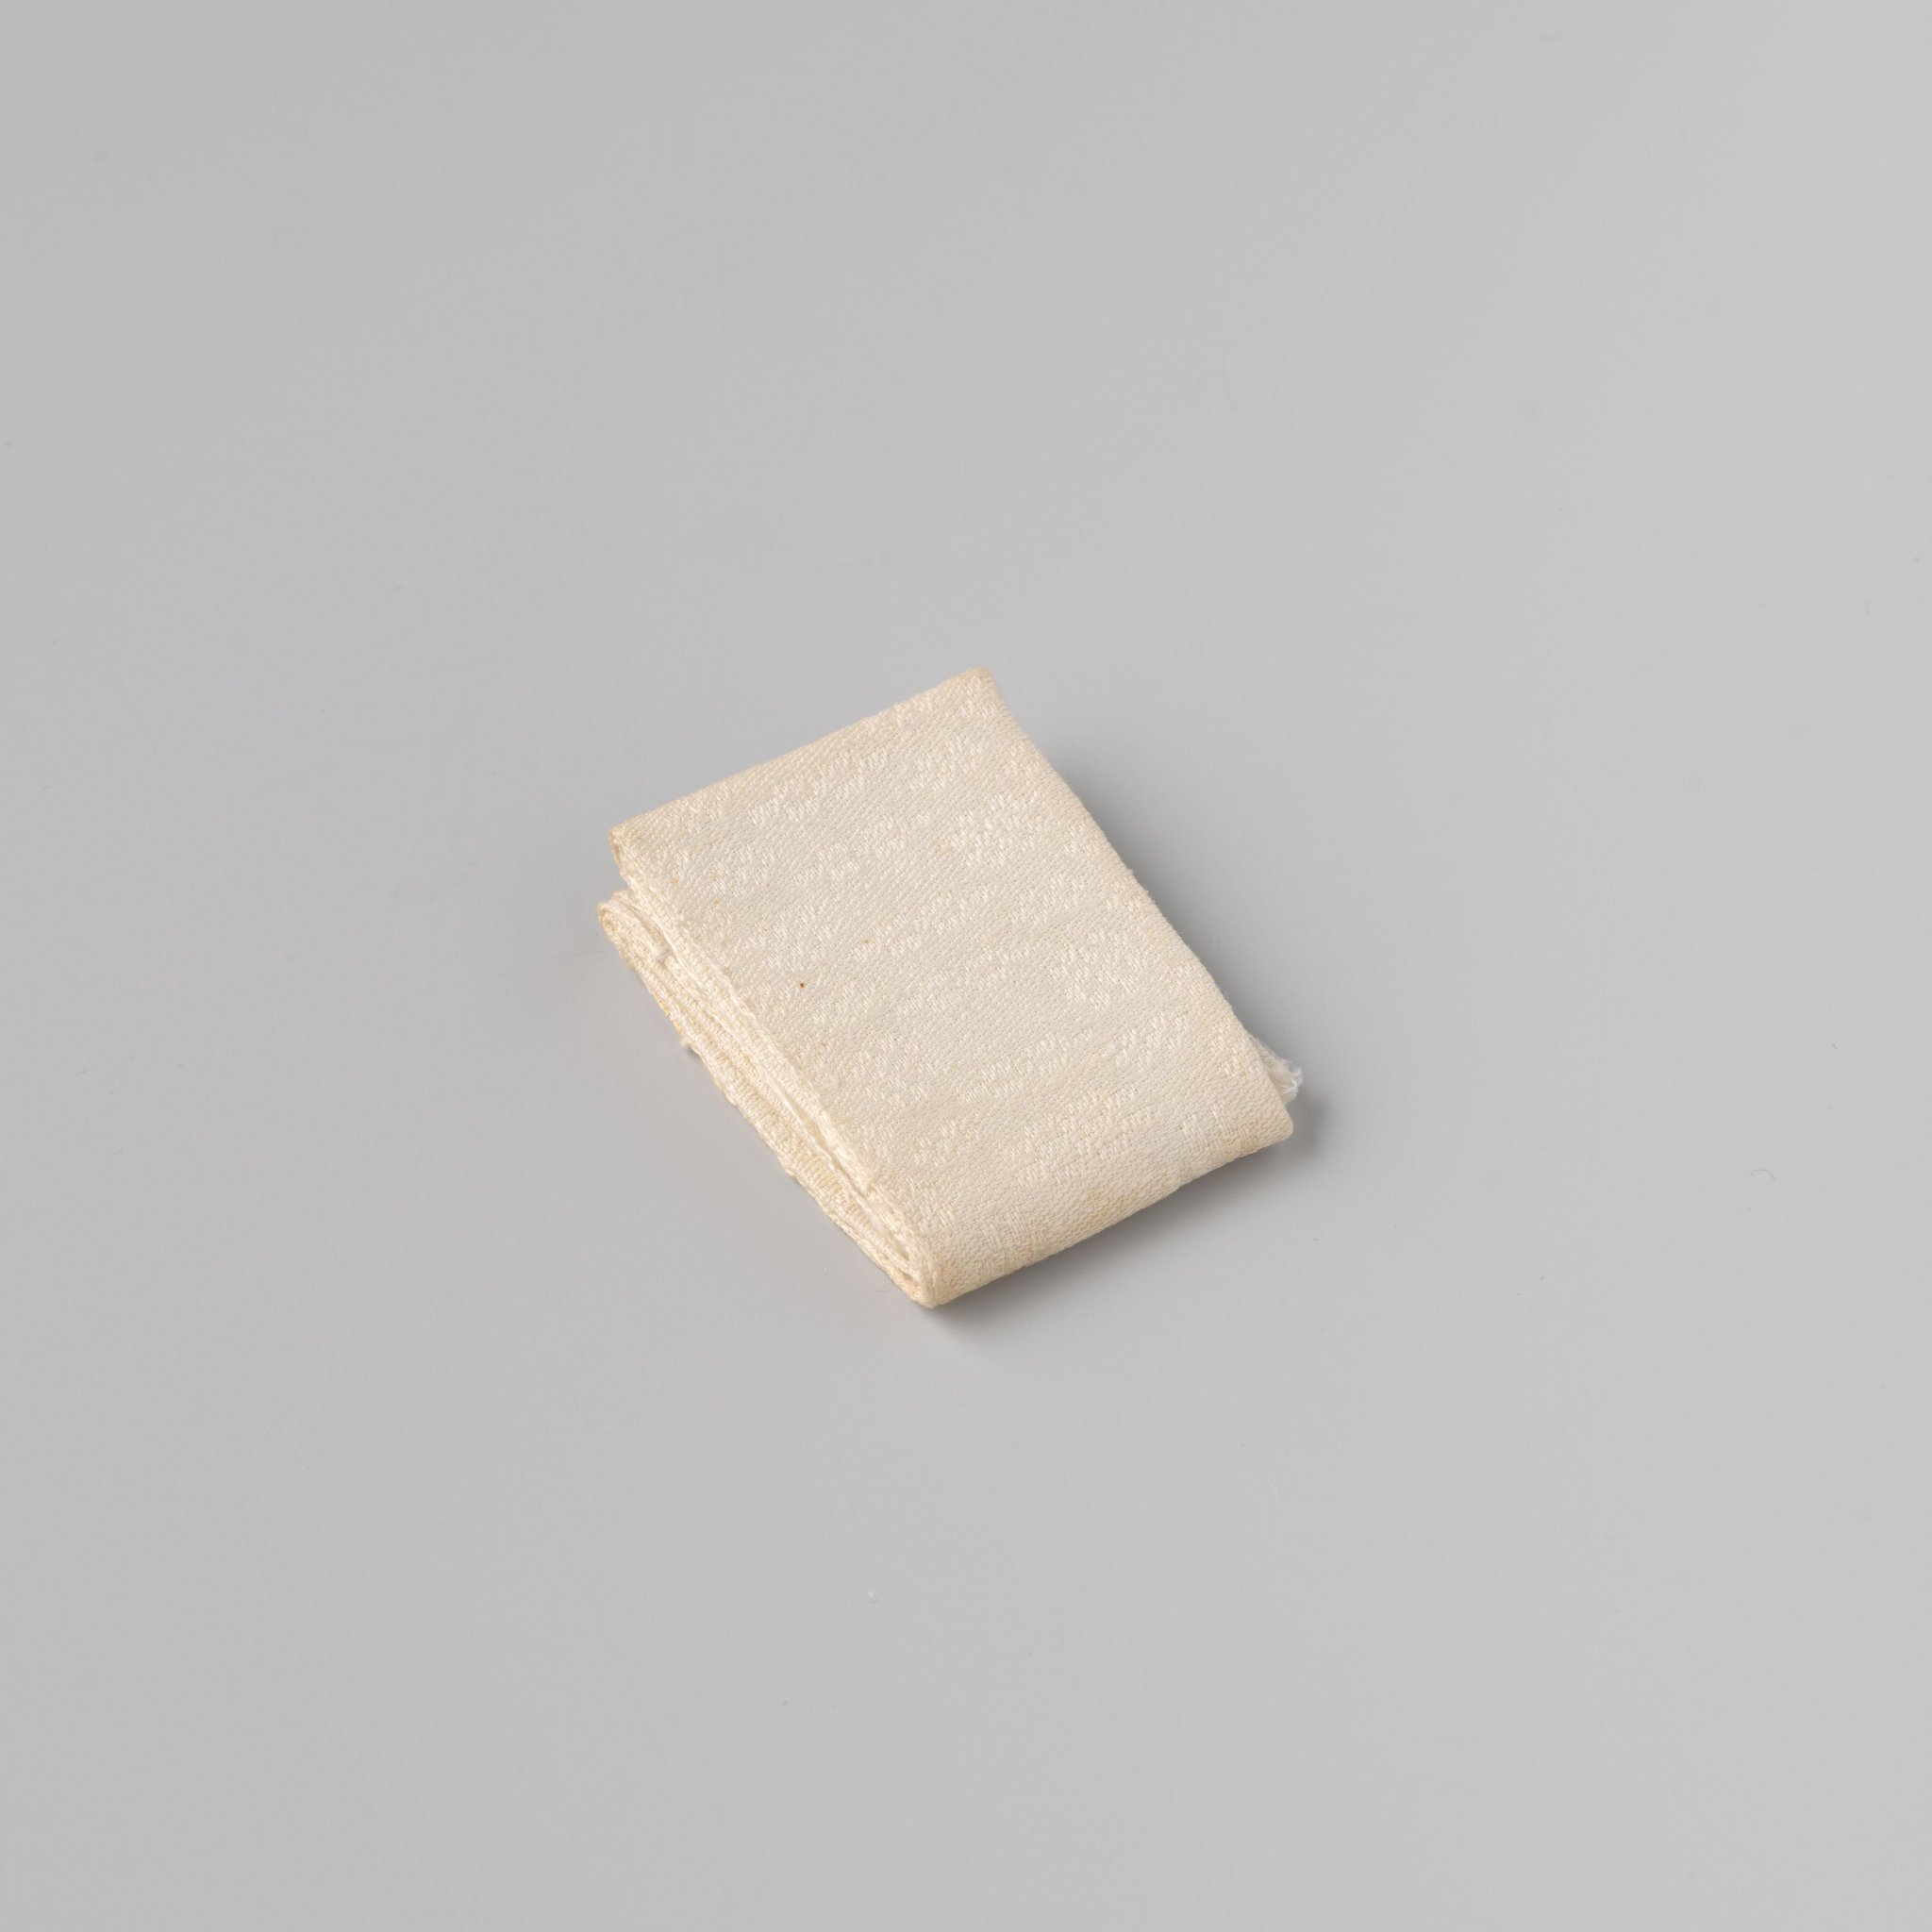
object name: napkin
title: Linnen servet van damastweefsel met pellenpatroon (motief III), geen zomen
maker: Anonymous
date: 1690-1710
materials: linen